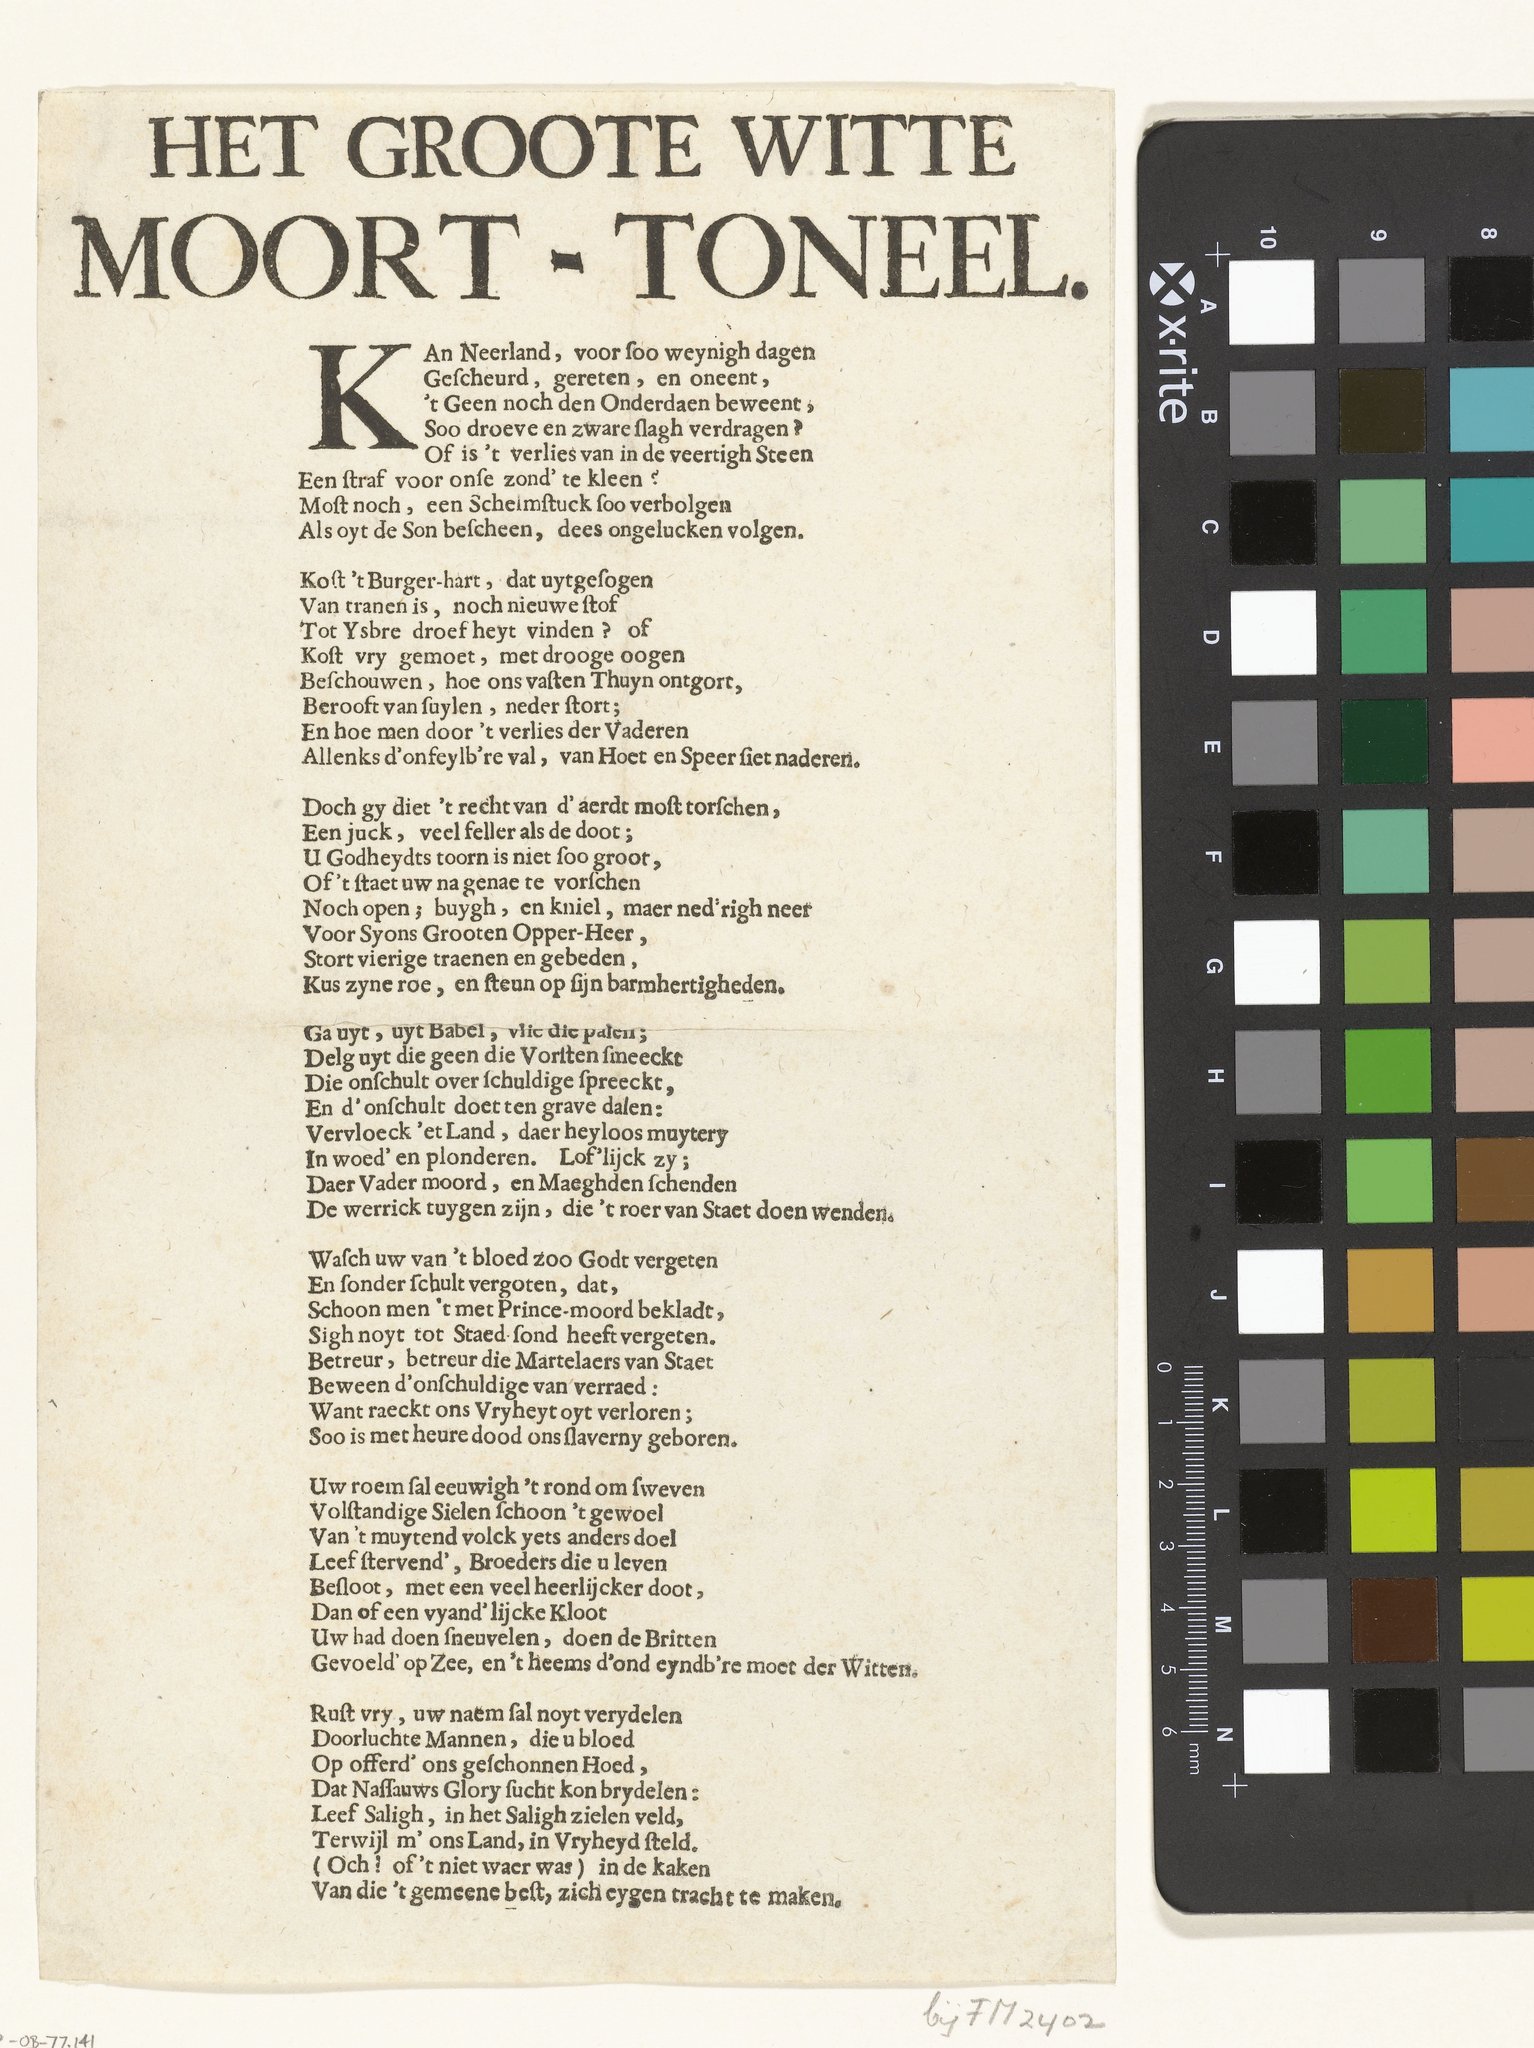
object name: text sheet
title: Vers op de dood van de gebroeders De Witt, 1672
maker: Anonymous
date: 1672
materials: paper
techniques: letterpress printing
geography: northern netherlands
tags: cornelis de witt, politician, johan de witt, the hague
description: Vers op de dood van de gebroeders De Witt, 20 augutsus 1672. Gedicht in zeven verzen van acht regels waarin de dood van Johan en Cornelis de Witt betreurd wordt.